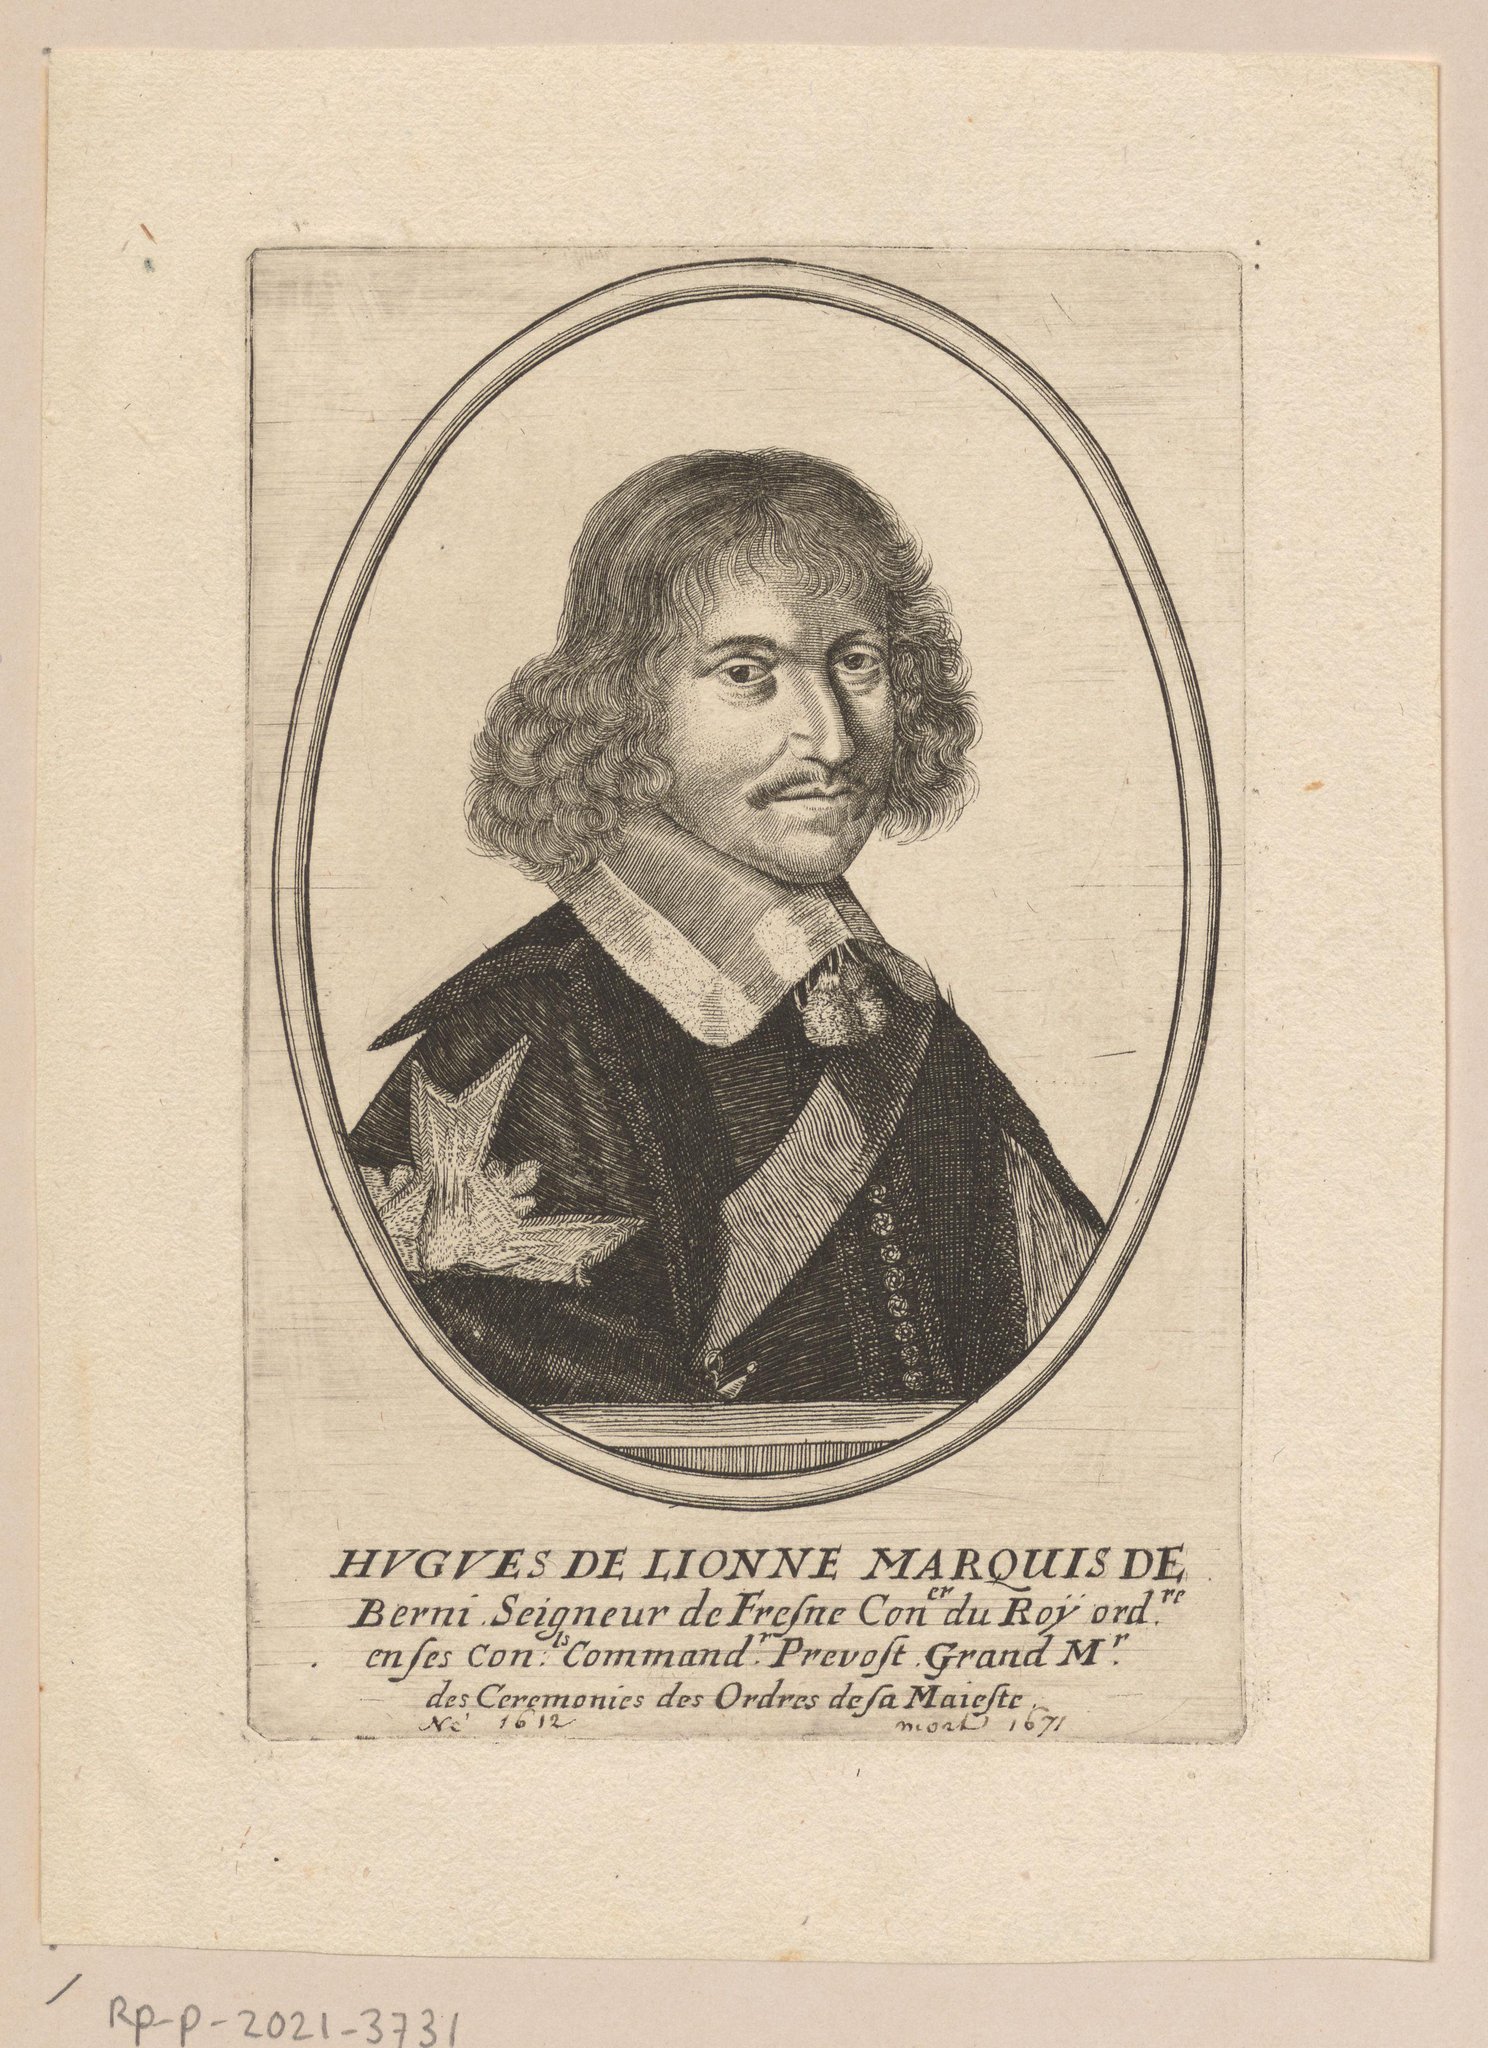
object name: print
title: Portret van Hugues de Lionne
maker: Anonymous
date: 1650-1680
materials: paper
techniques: engraving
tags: paris, historical persons, politician, e.g. party leader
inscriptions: inscription: ‘Né 1612/ mort 1671’